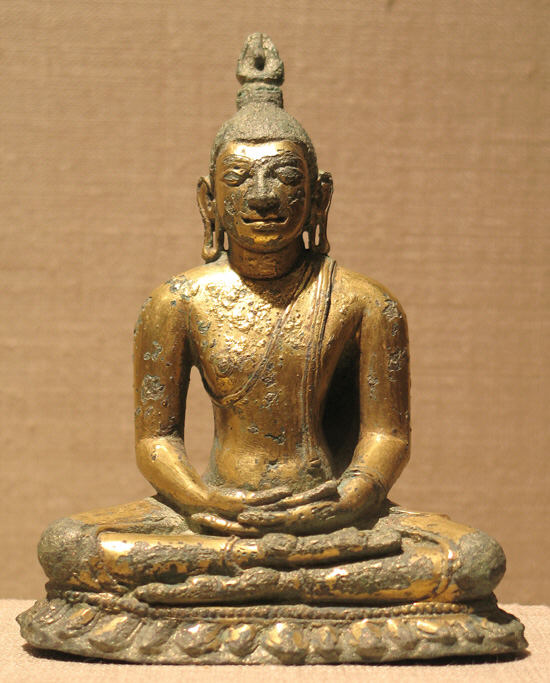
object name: figure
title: Seated Buddha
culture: sri lankan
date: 801-900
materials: gilt bronze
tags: buddhism,buddha